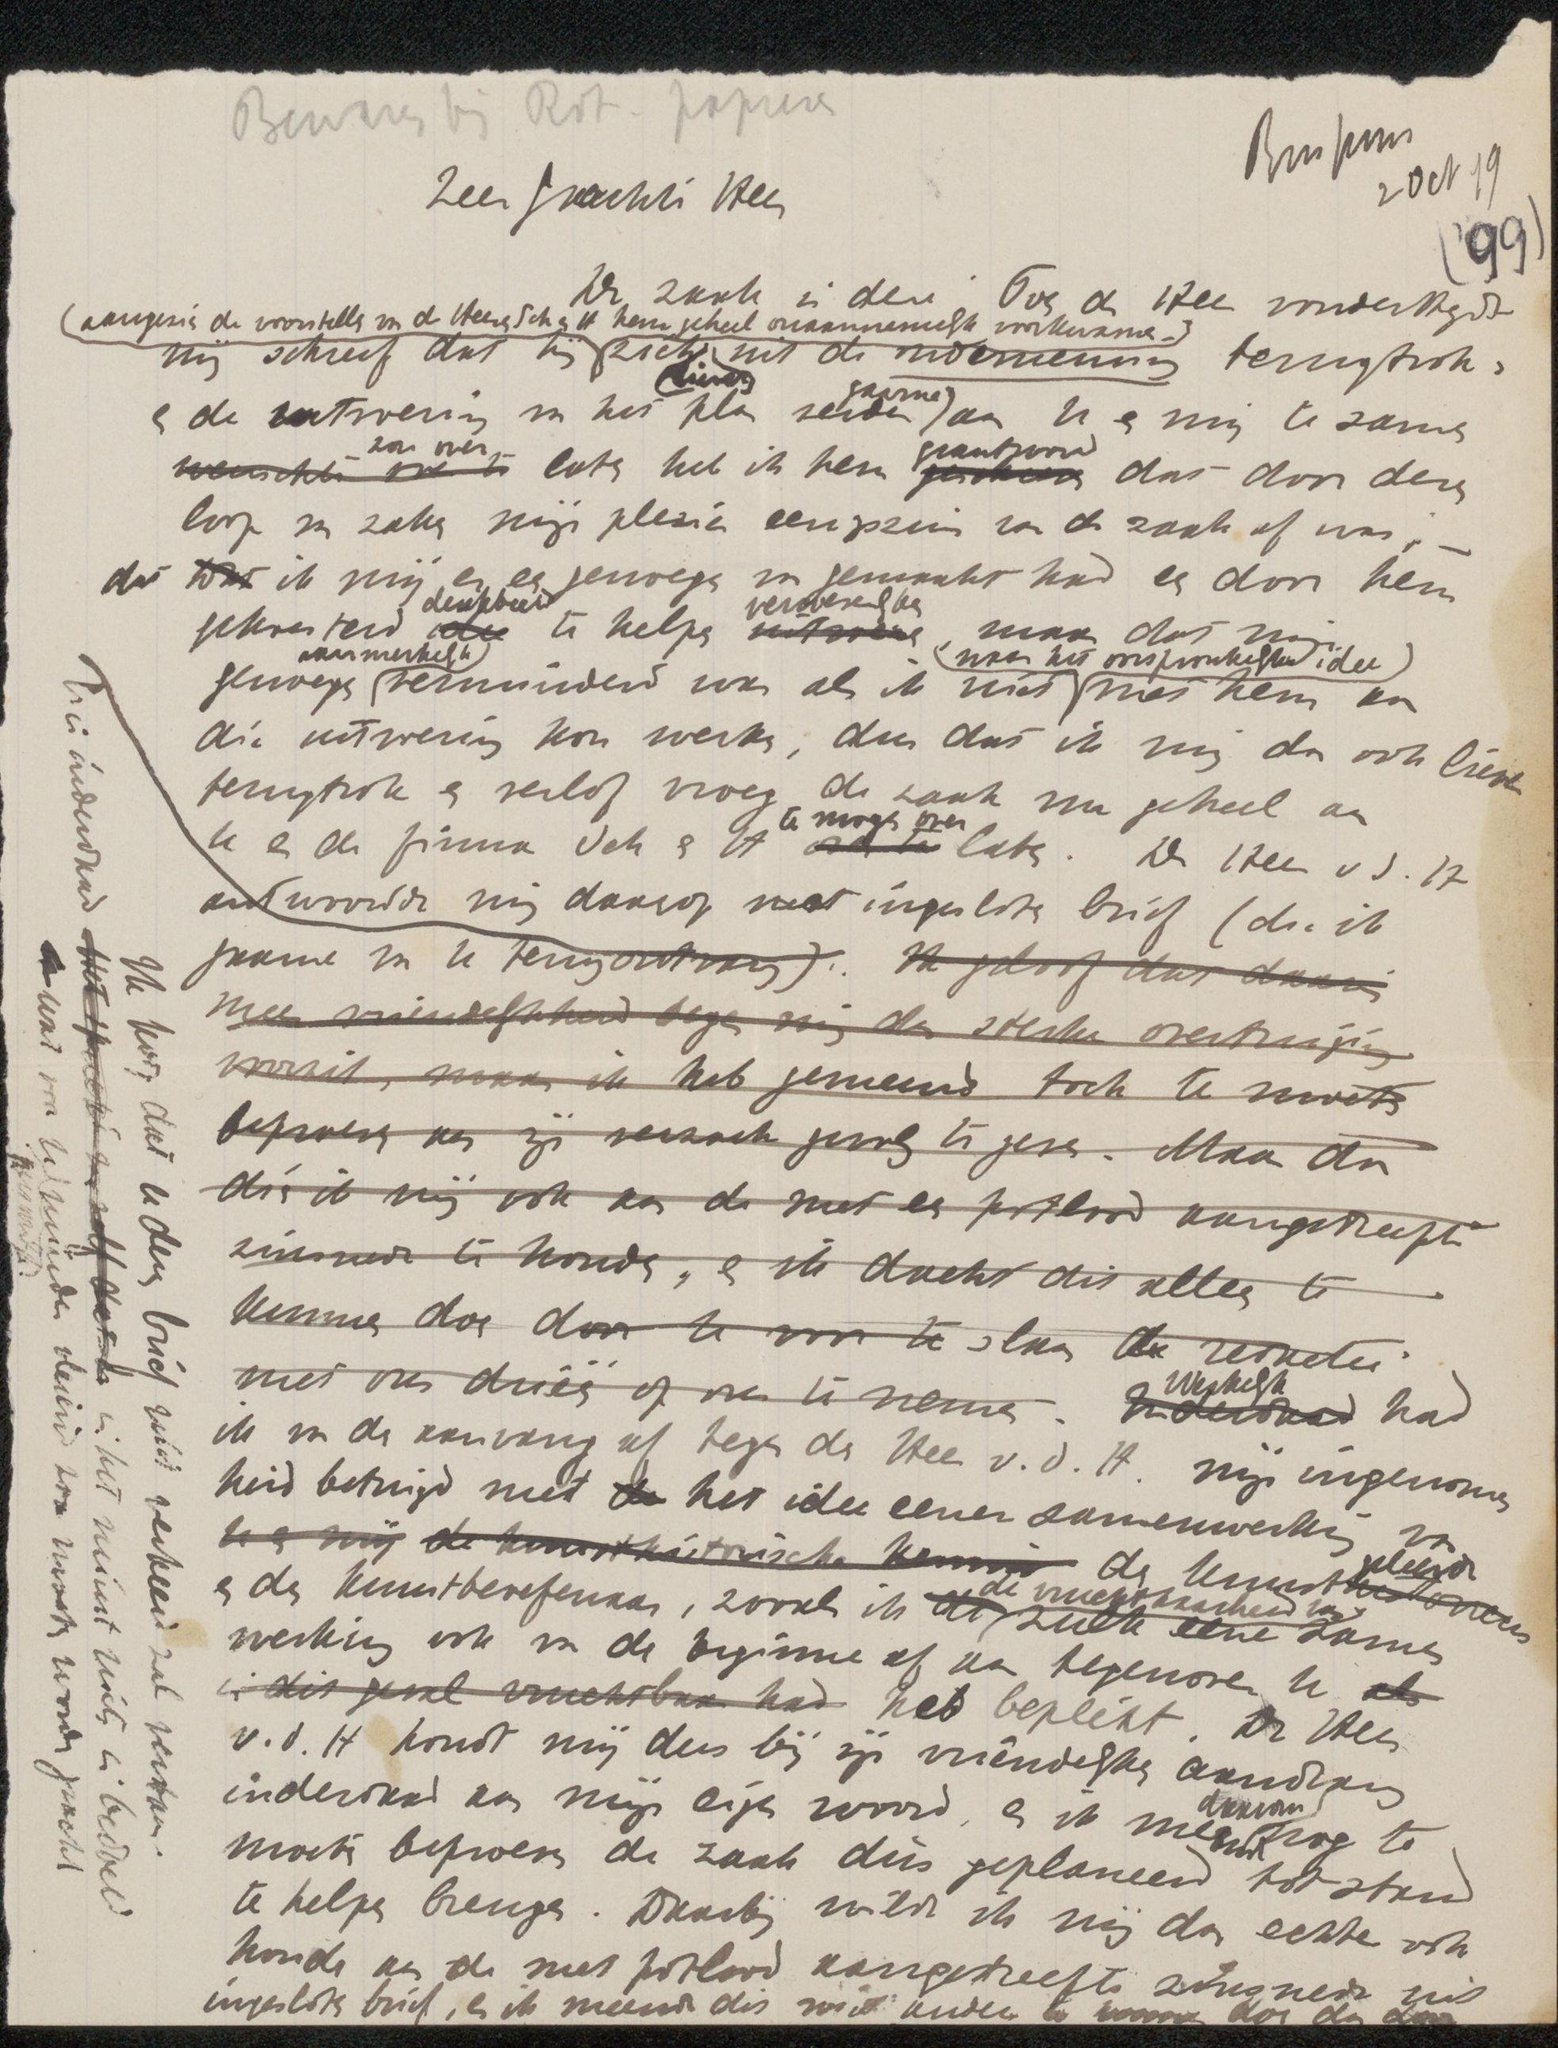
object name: letter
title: Brief aan Cornelis Hofstede de Groot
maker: jan veth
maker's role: designer, draughtsman, painter, print maker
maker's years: 1864-1925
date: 1899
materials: ink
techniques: pen, writing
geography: bussum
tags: cornelis hofstede de groot, berlin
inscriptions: collector's mark: ‘RPK’